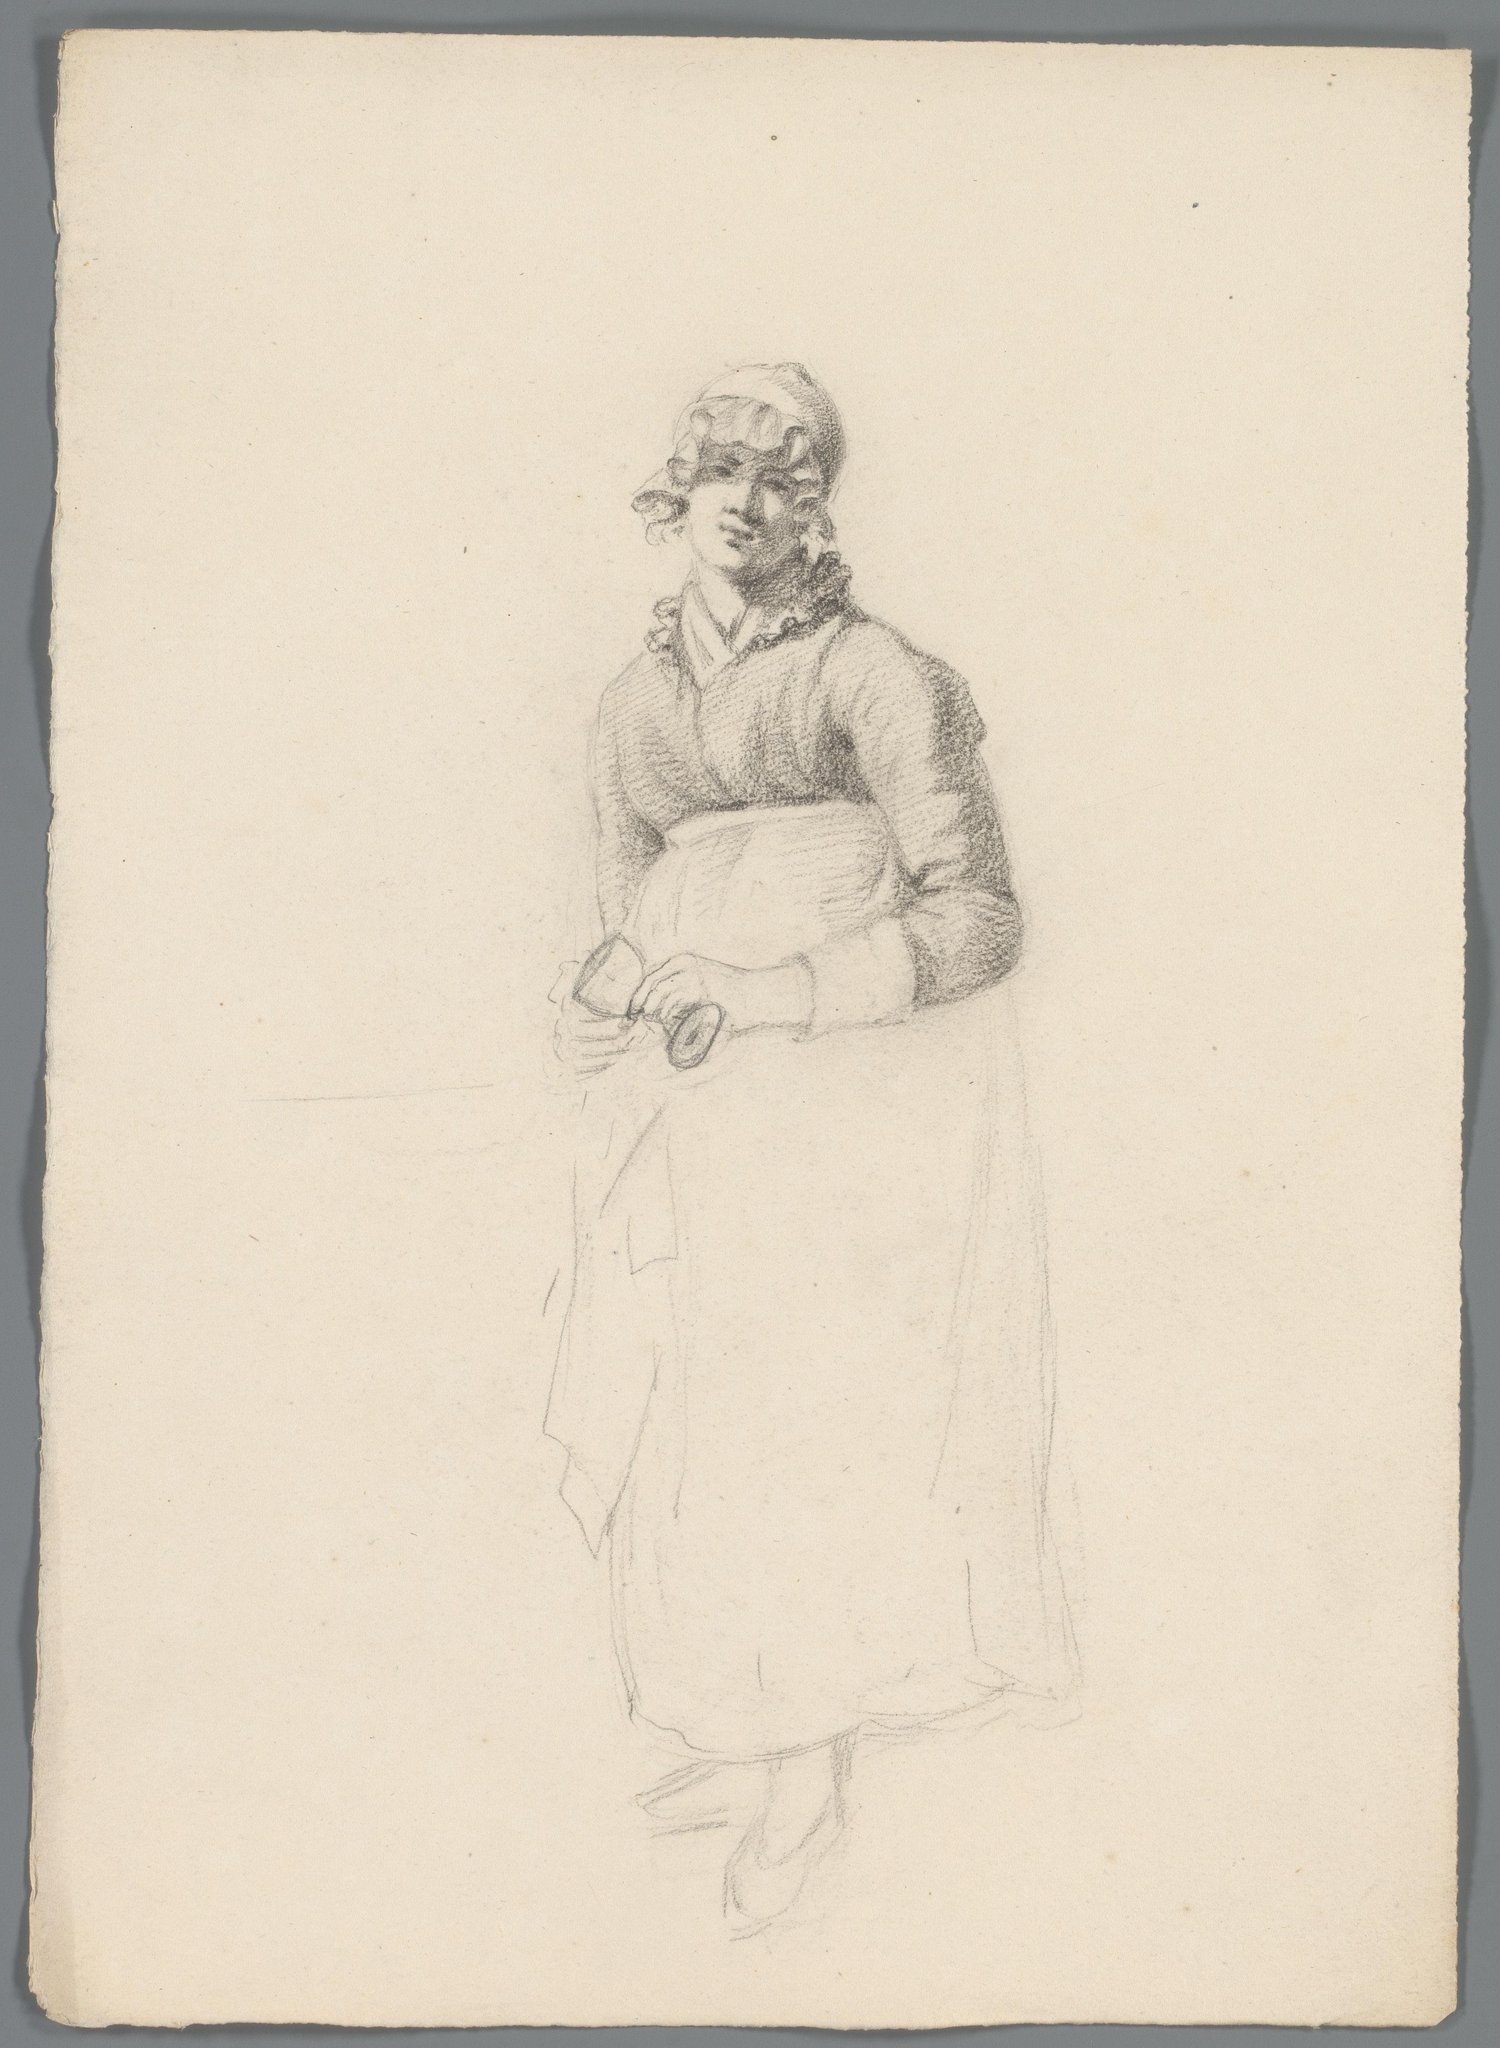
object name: drawing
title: Vrouw met een wijnglas in haar hand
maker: Anonymous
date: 1820-1830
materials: chalk, paper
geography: the hague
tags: adult woman, glass of wine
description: Tekeningen waarschijnlijk ontstaan bij het Haagse kunstgenootschap ‘Tot Nut der Tekenkunst’, waar twee keer per week tekenavonden werden georganiseerd met geklede modellen.